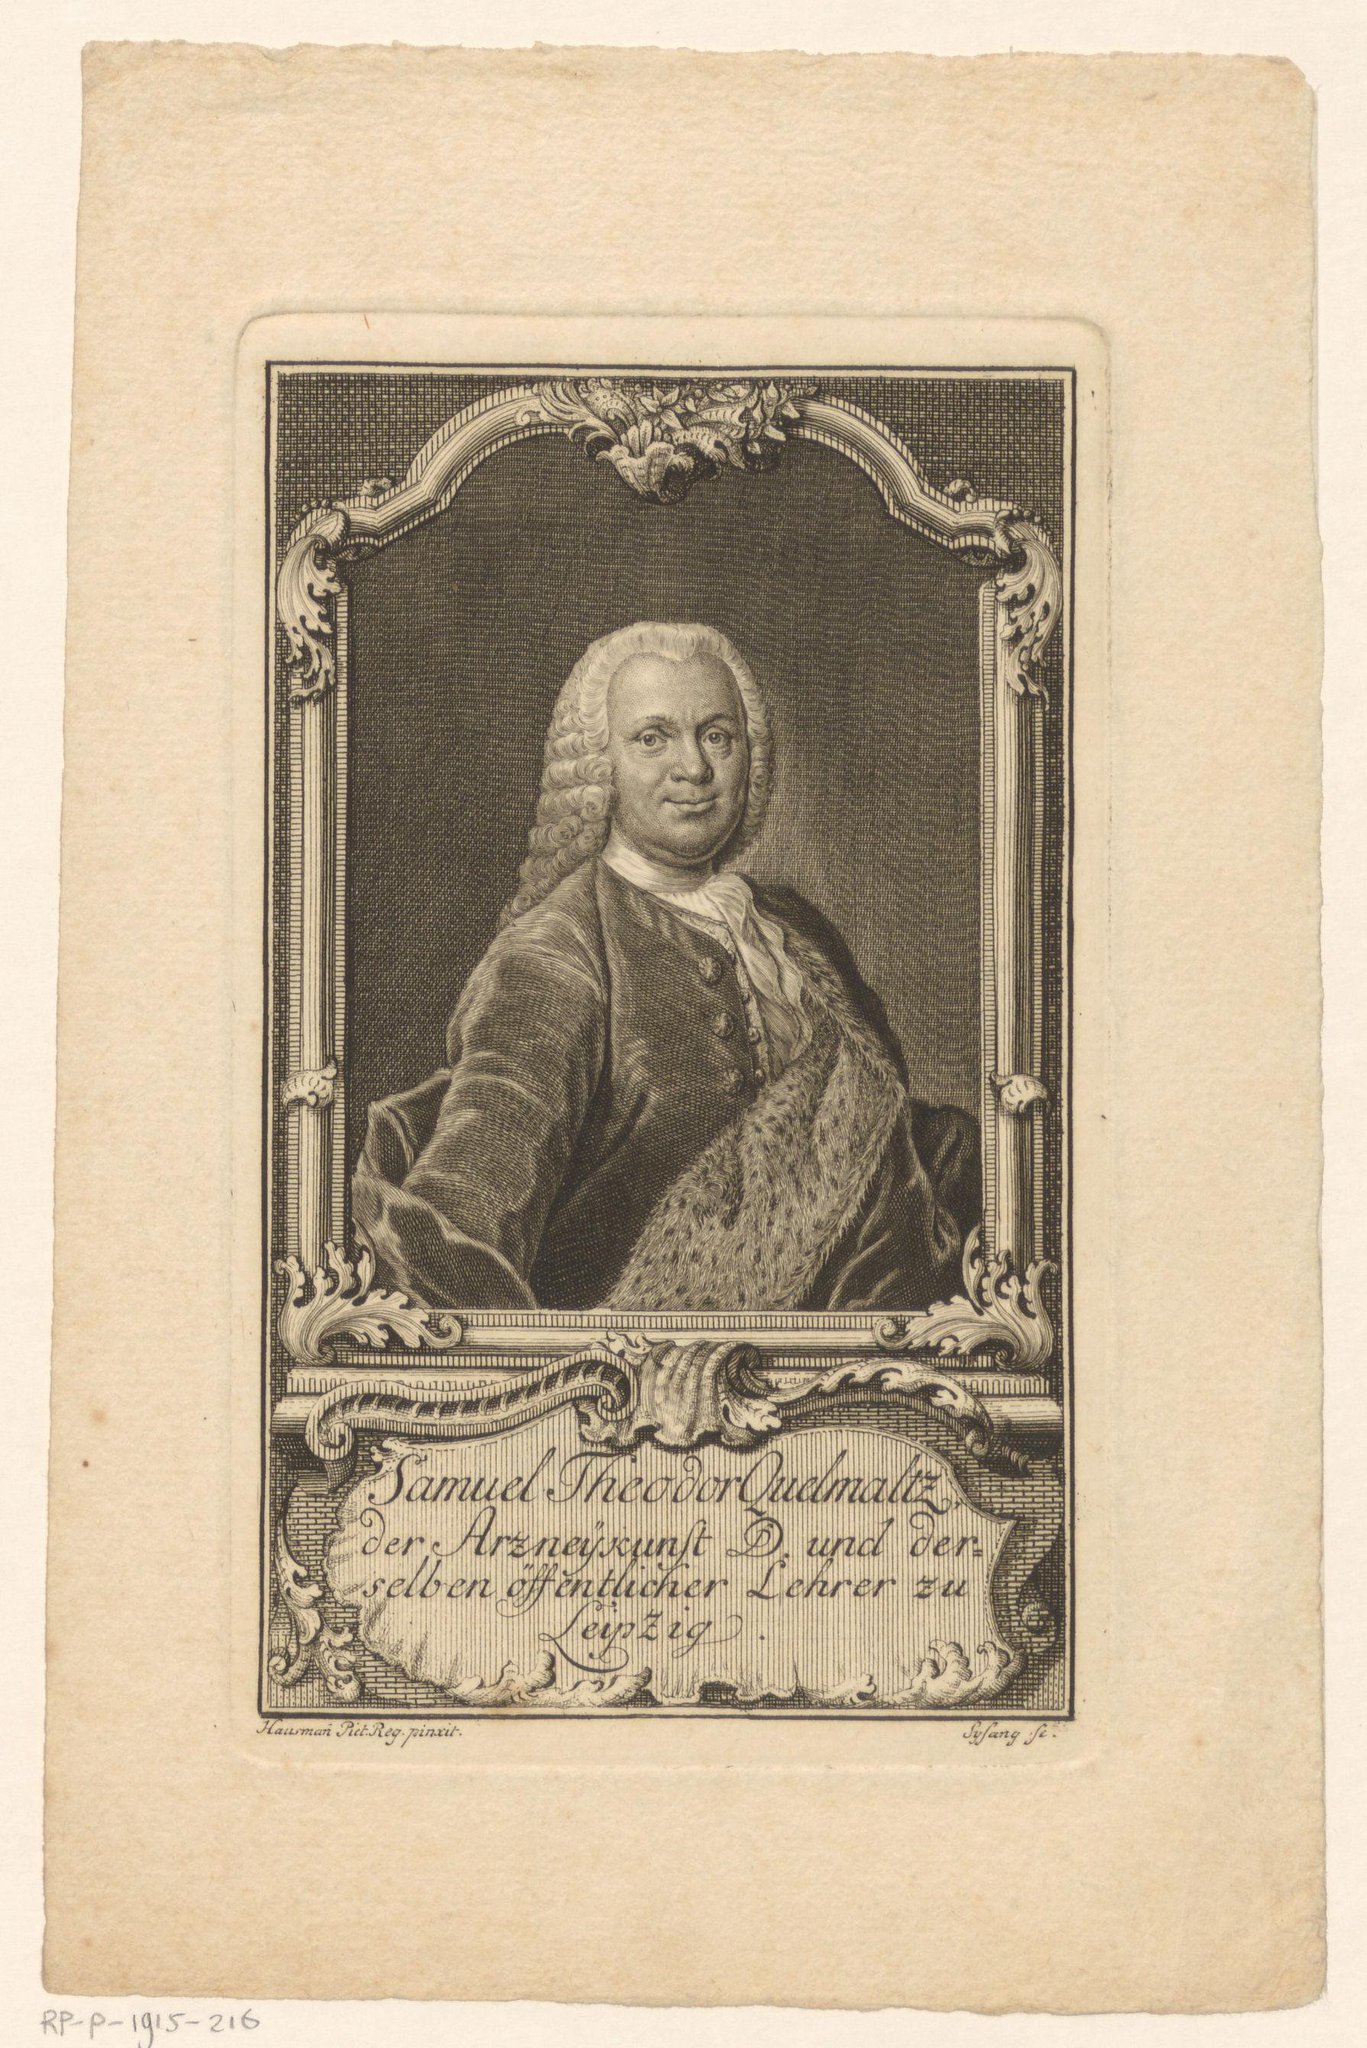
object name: print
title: Portret van Samuel Theodor Quellmaltz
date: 1726-1757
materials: paper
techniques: engraving, etching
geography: germany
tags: historical persons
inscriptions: collector's mark: Lugt 2228